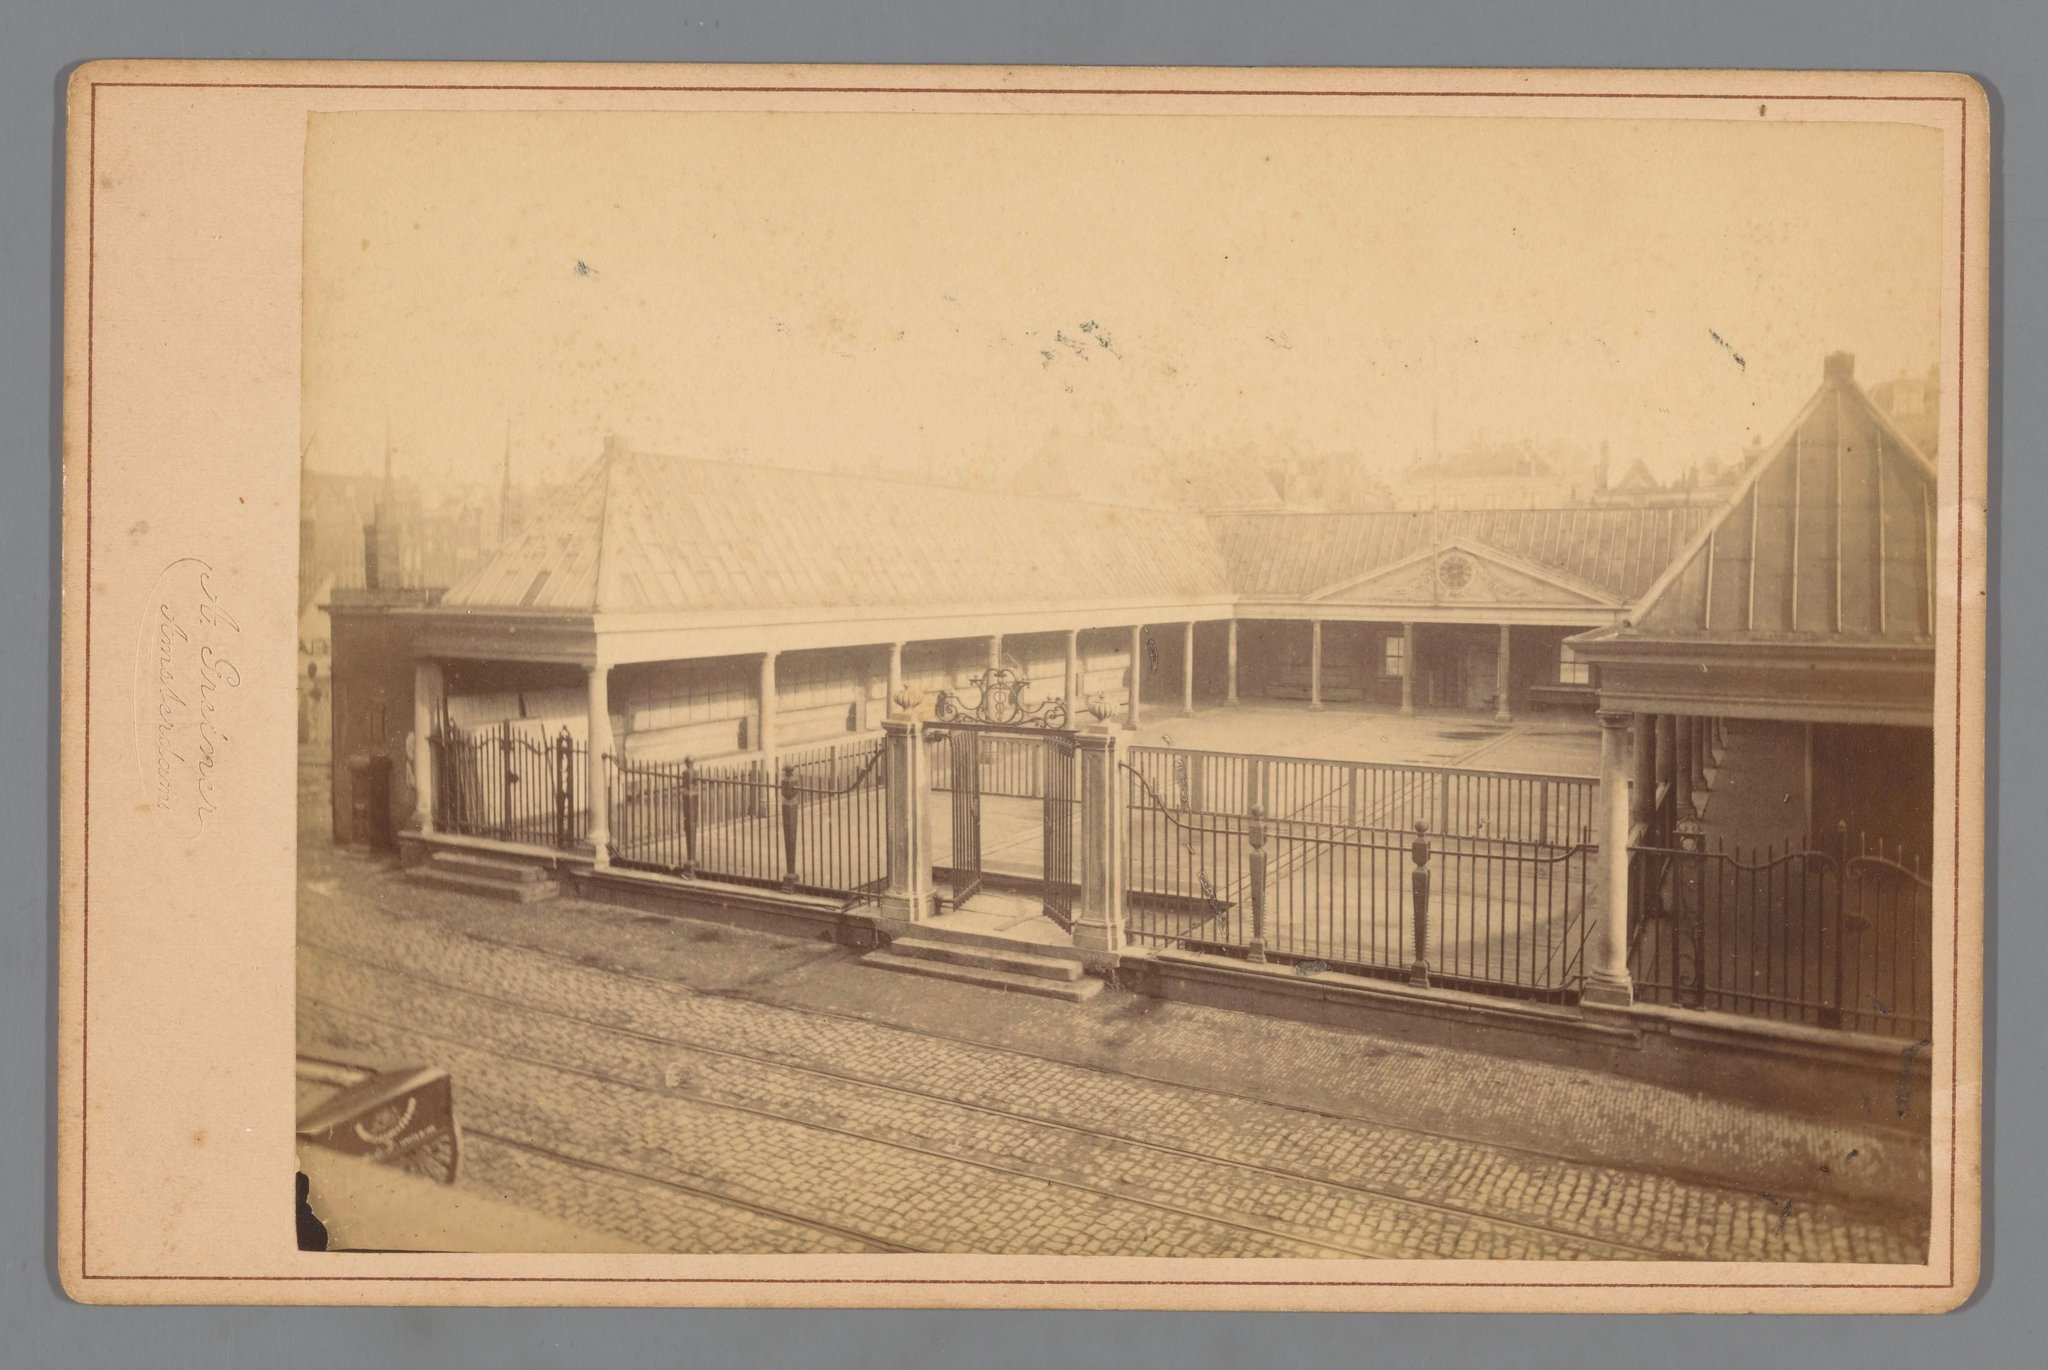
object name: cabinet photograph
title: Gezicht op de Korenbeurs in Amsterdam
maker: albert greiner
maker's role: fotograaf, fotostudio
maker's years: 1833-1890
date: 1861-1884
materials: cardboard, photographic support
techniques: albumen print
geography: amsterdam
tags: flour- and grain-products, locations for trading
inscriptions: annotation: ‘Korenbeurs - afgebroken/ in 1884.’